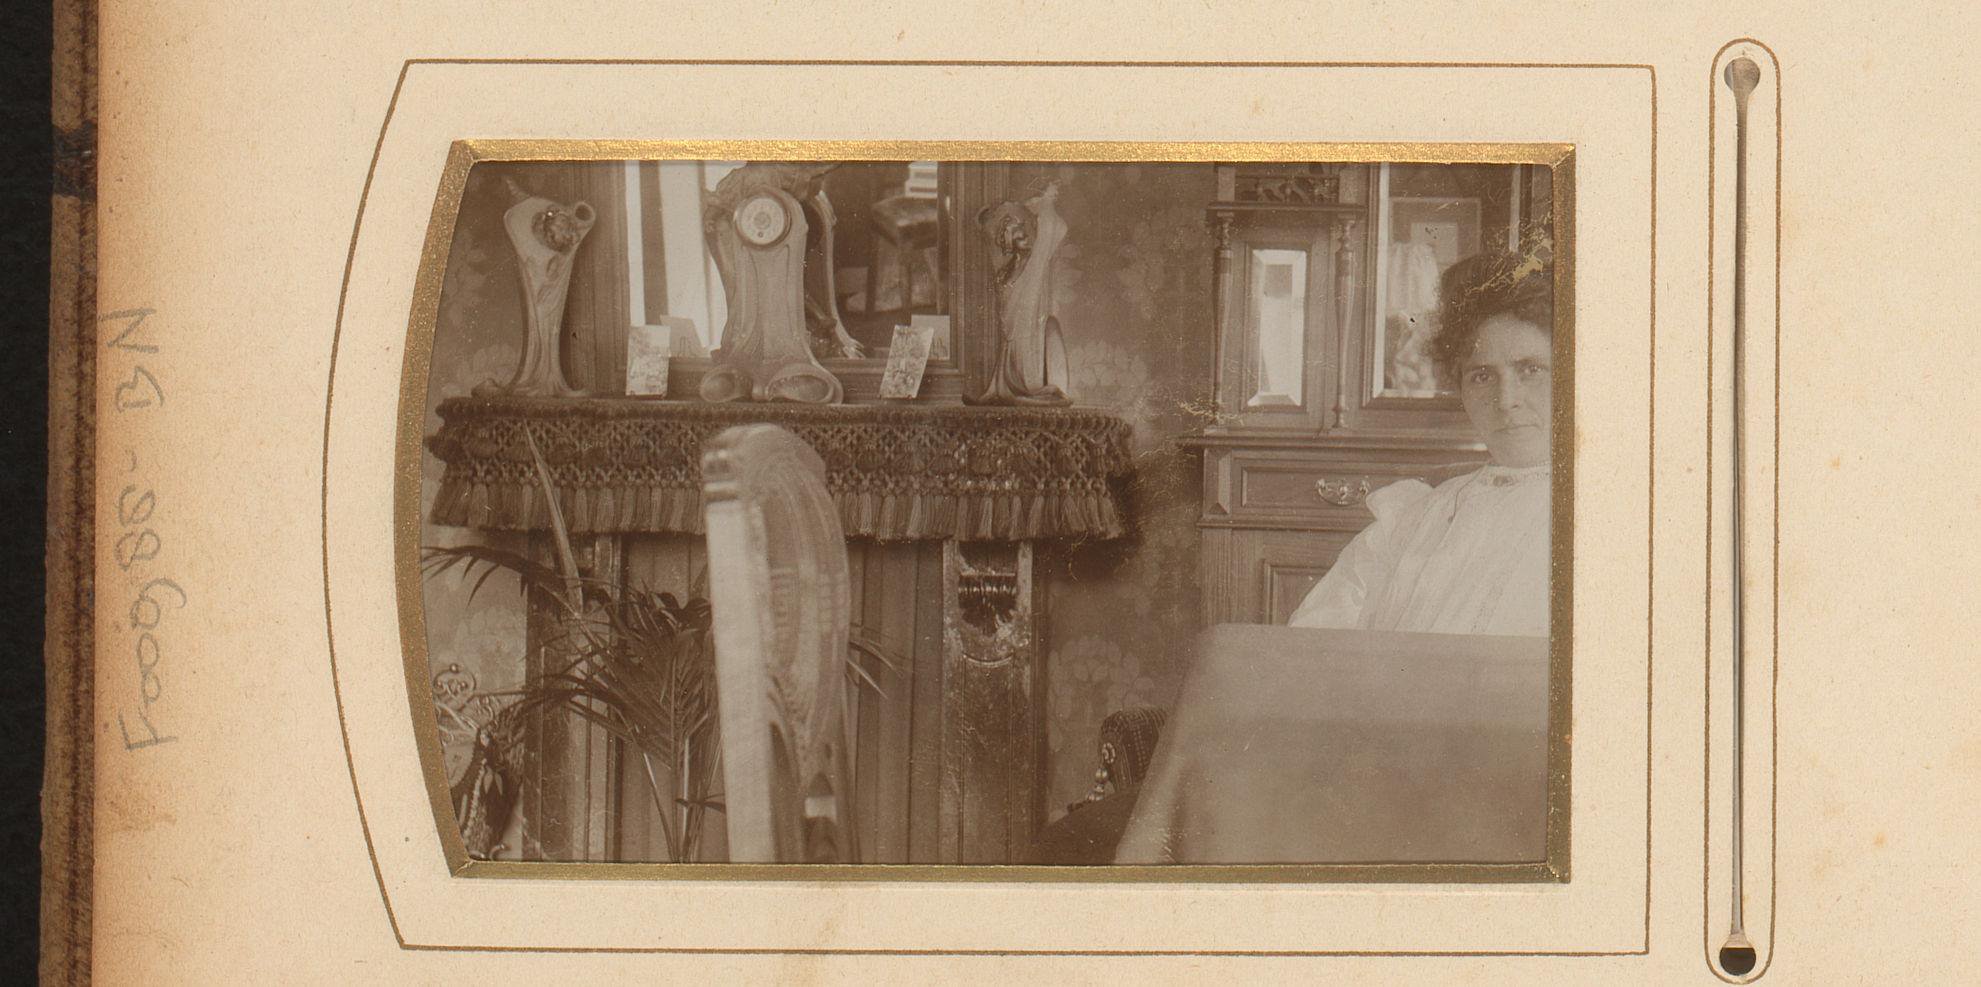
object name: photograph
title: Interieur met een vrouw en Art Nouveau voorwerpen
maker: Anonymous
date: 1900-1915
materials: photographic support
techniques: collodion silver print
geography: netherlands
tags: adult woman, living-room, parlour, sitting-room